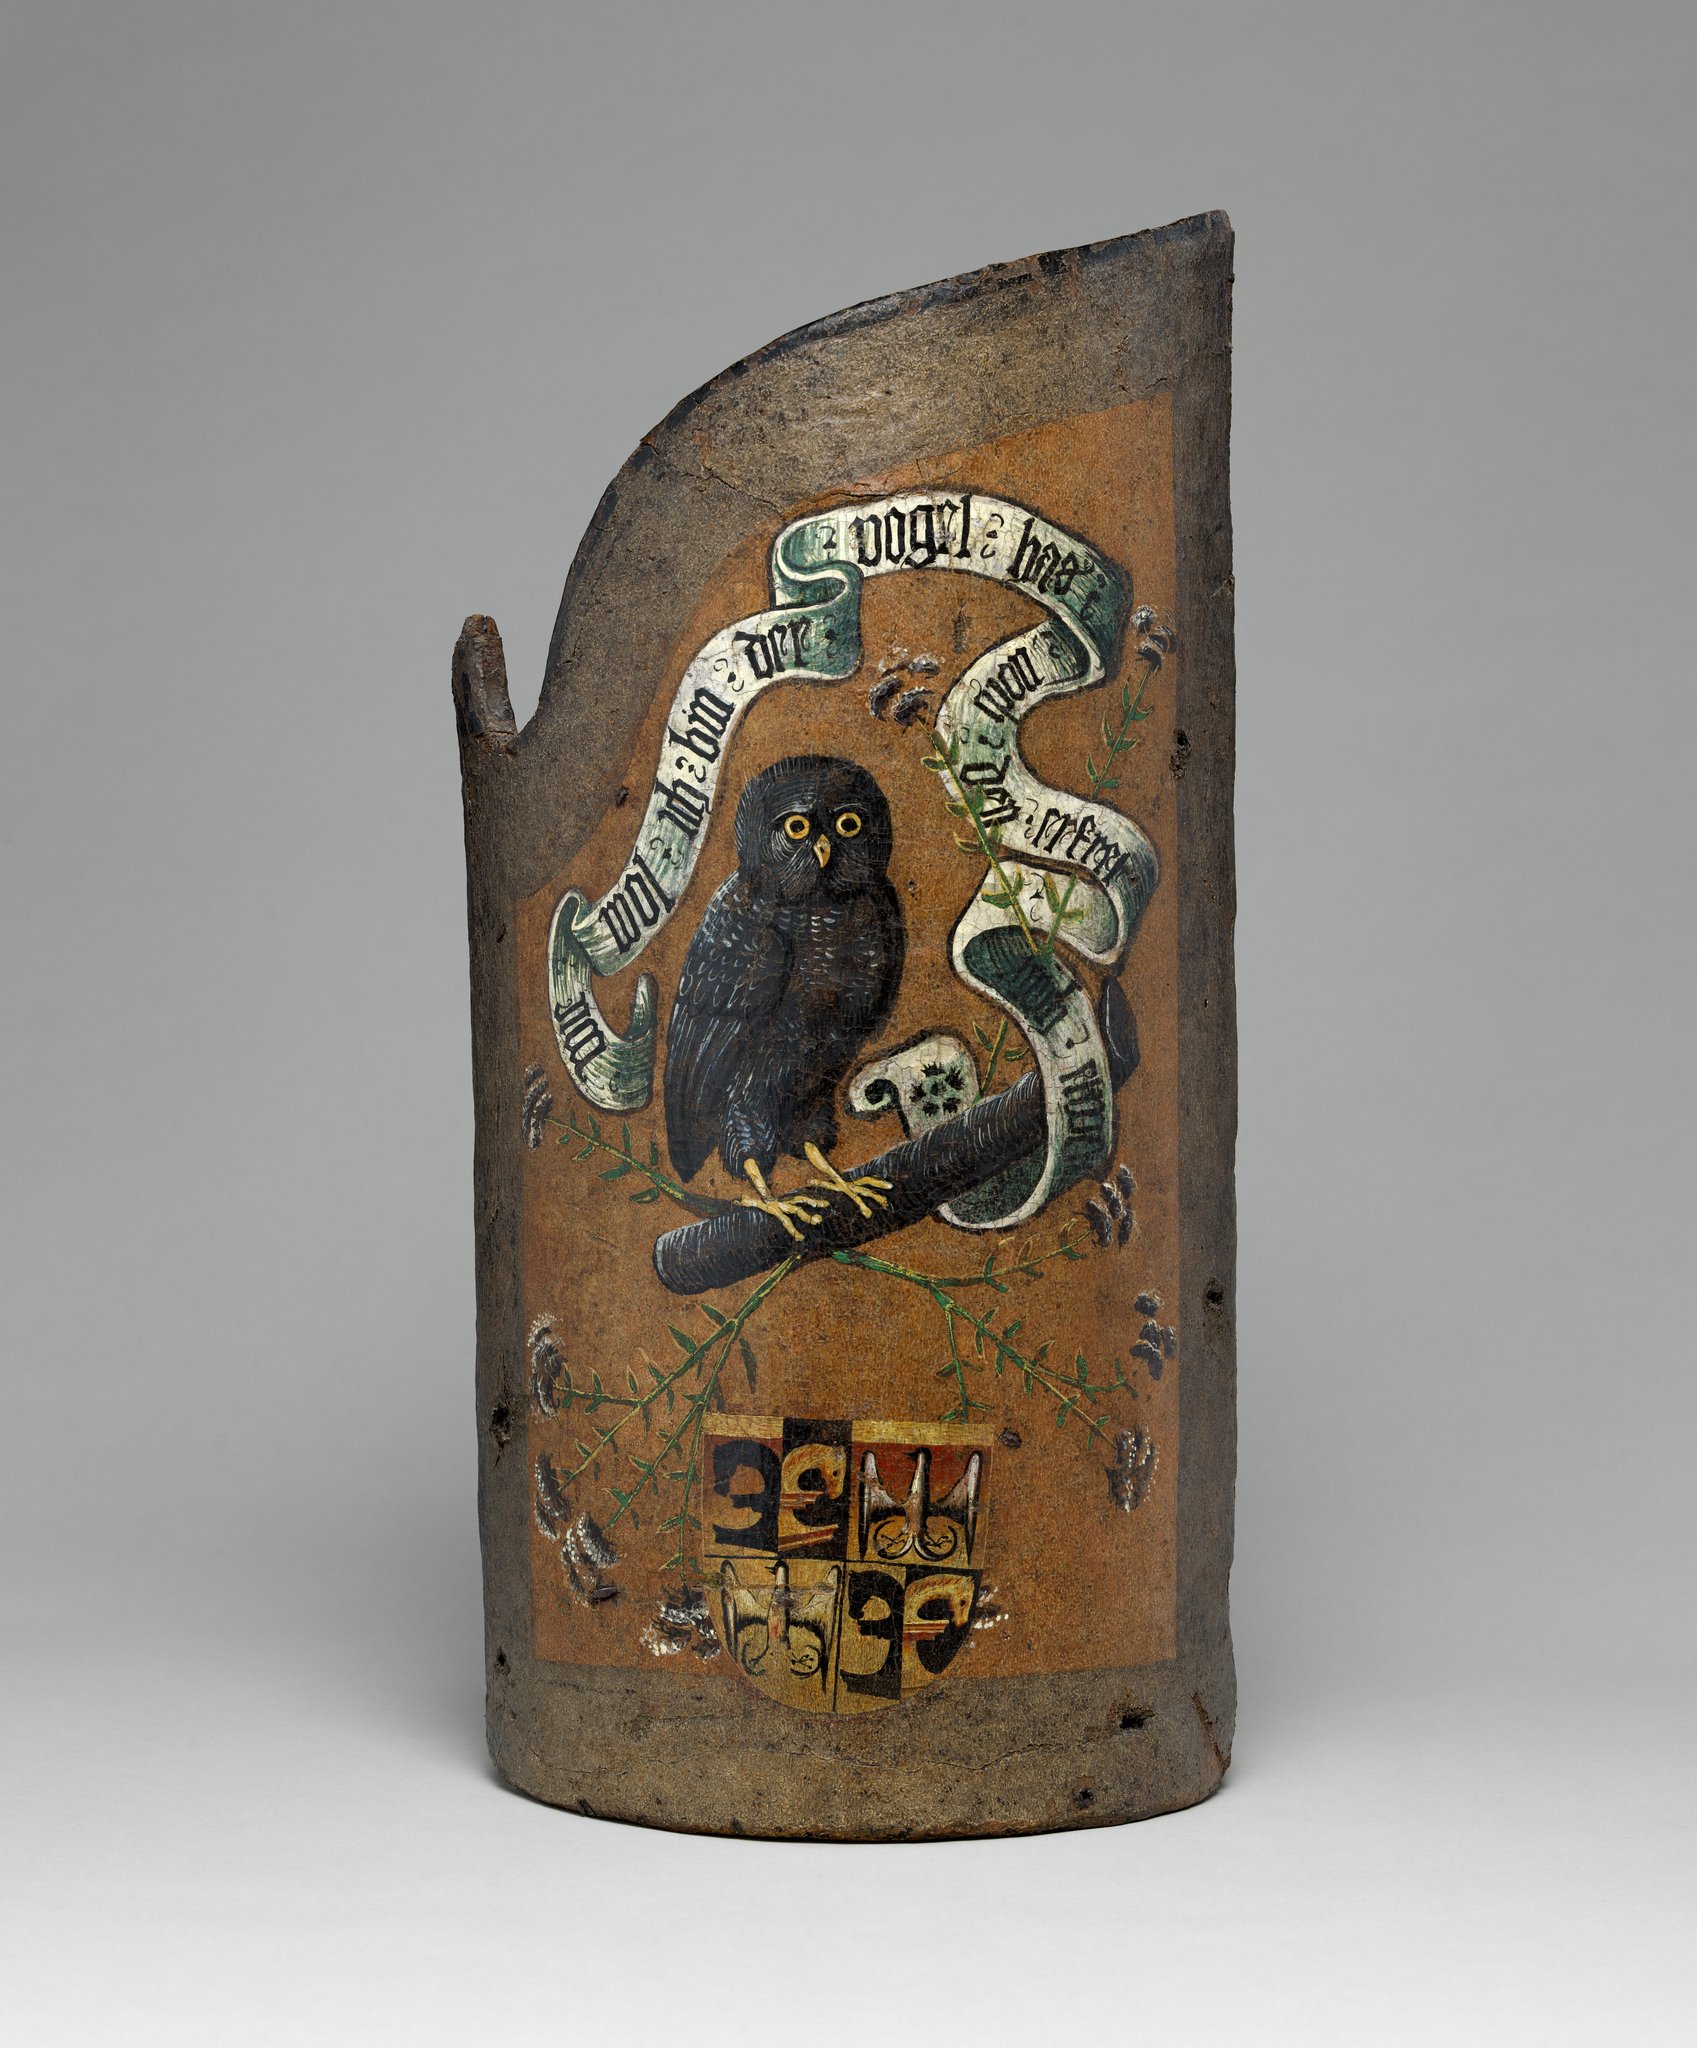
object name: tournament shield targe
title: Tournament Shield (Targe)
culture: german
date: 1500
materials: gesso, leather, wood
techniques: polychromy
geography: germany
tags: owls,coat of arms